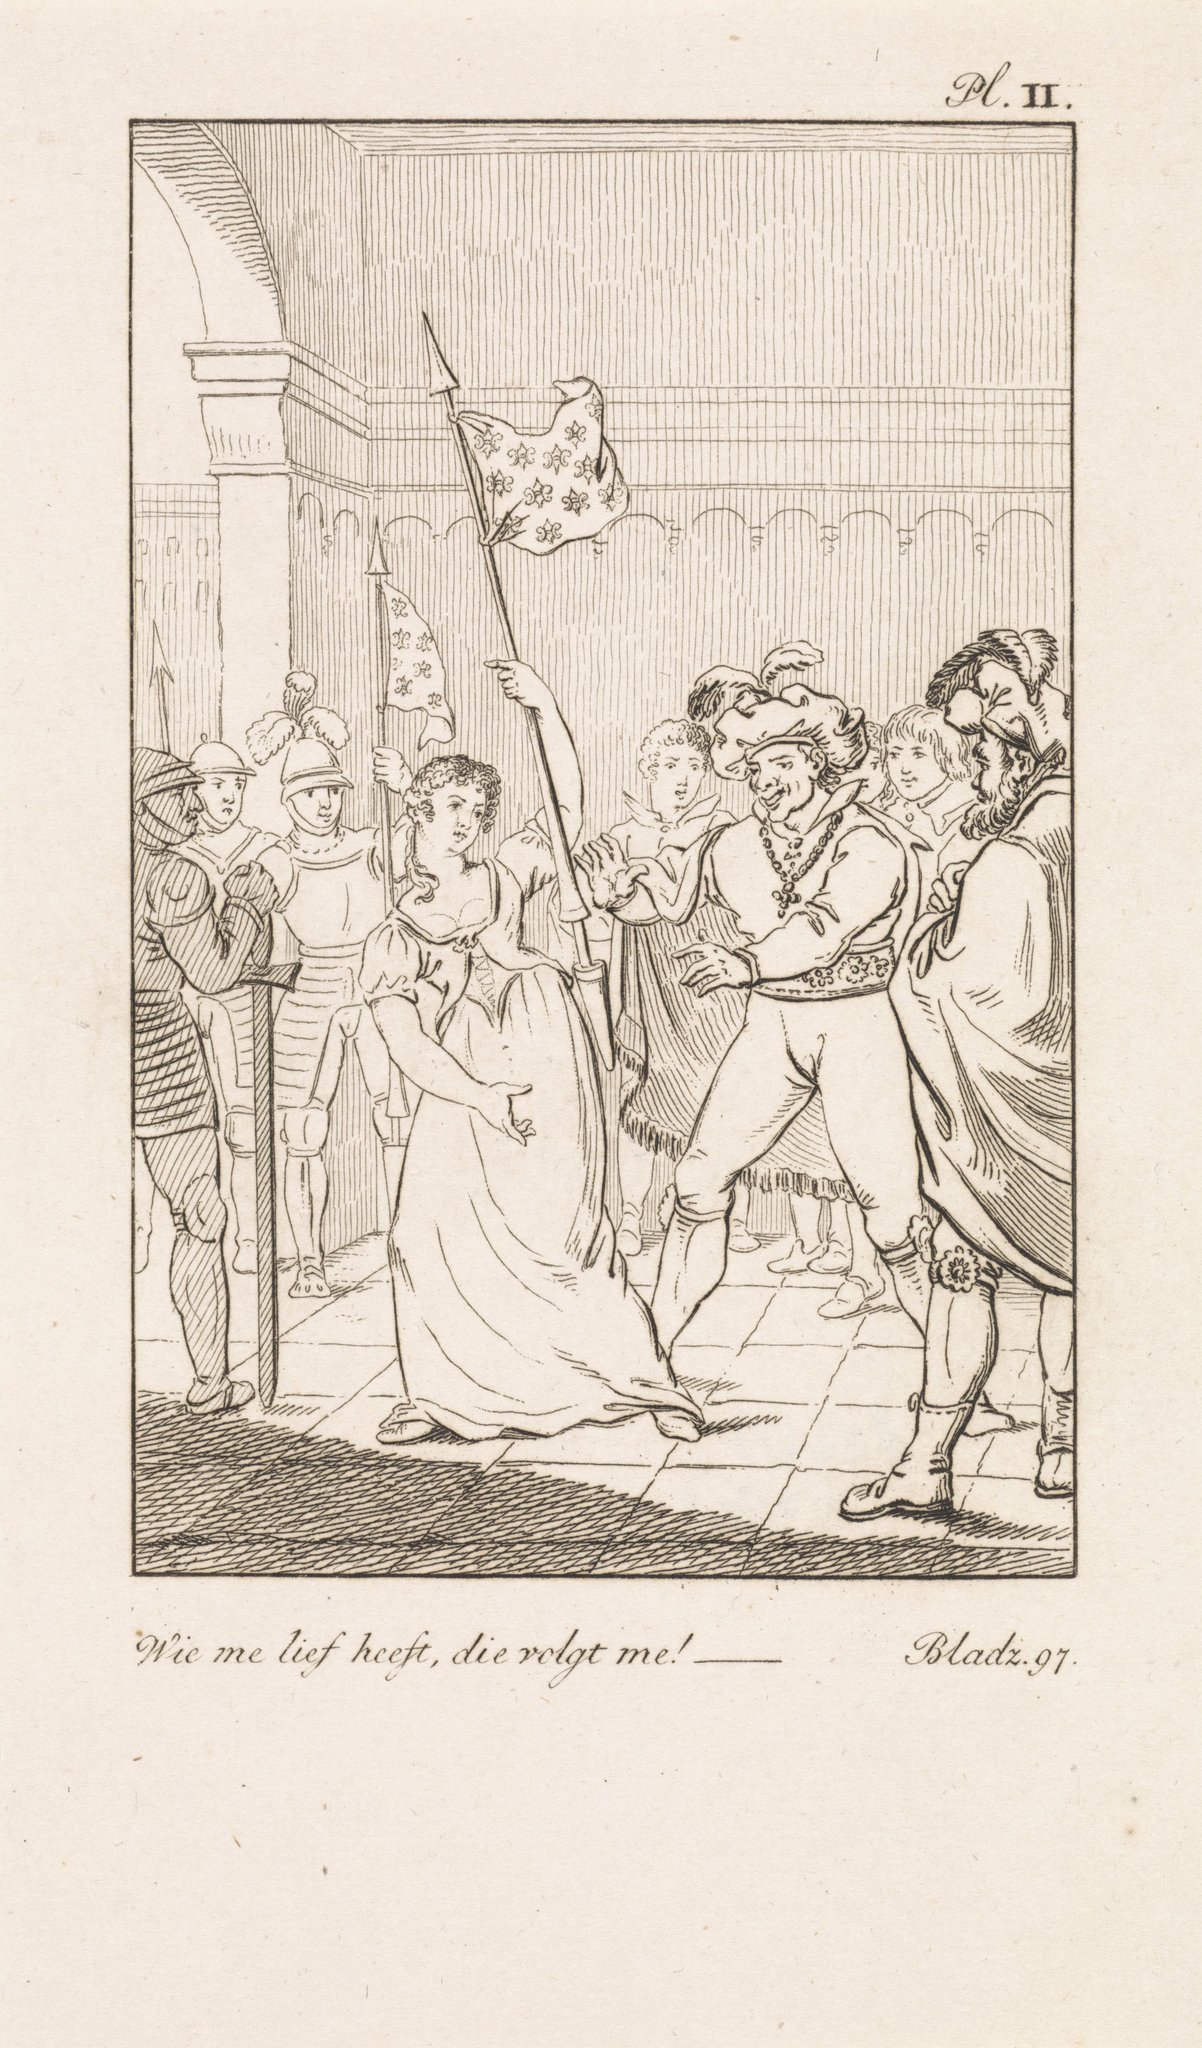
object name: print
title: Wie me lief heeft, die volgt me! -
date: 1802-1809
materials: paper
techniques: etching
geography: haarlem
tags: political caricatures and satires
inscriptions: collector's mark: Lugt 2228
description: Prent als boekillustratie gebruikt in: Fokke Simonsz., Arend. Het hoekjen van den haard of Historie van Frankrijk. Deel IV-VII uit: Boertige Reis door Europa. 7 dln. Haarlem: François Bohn, 1802-1809.